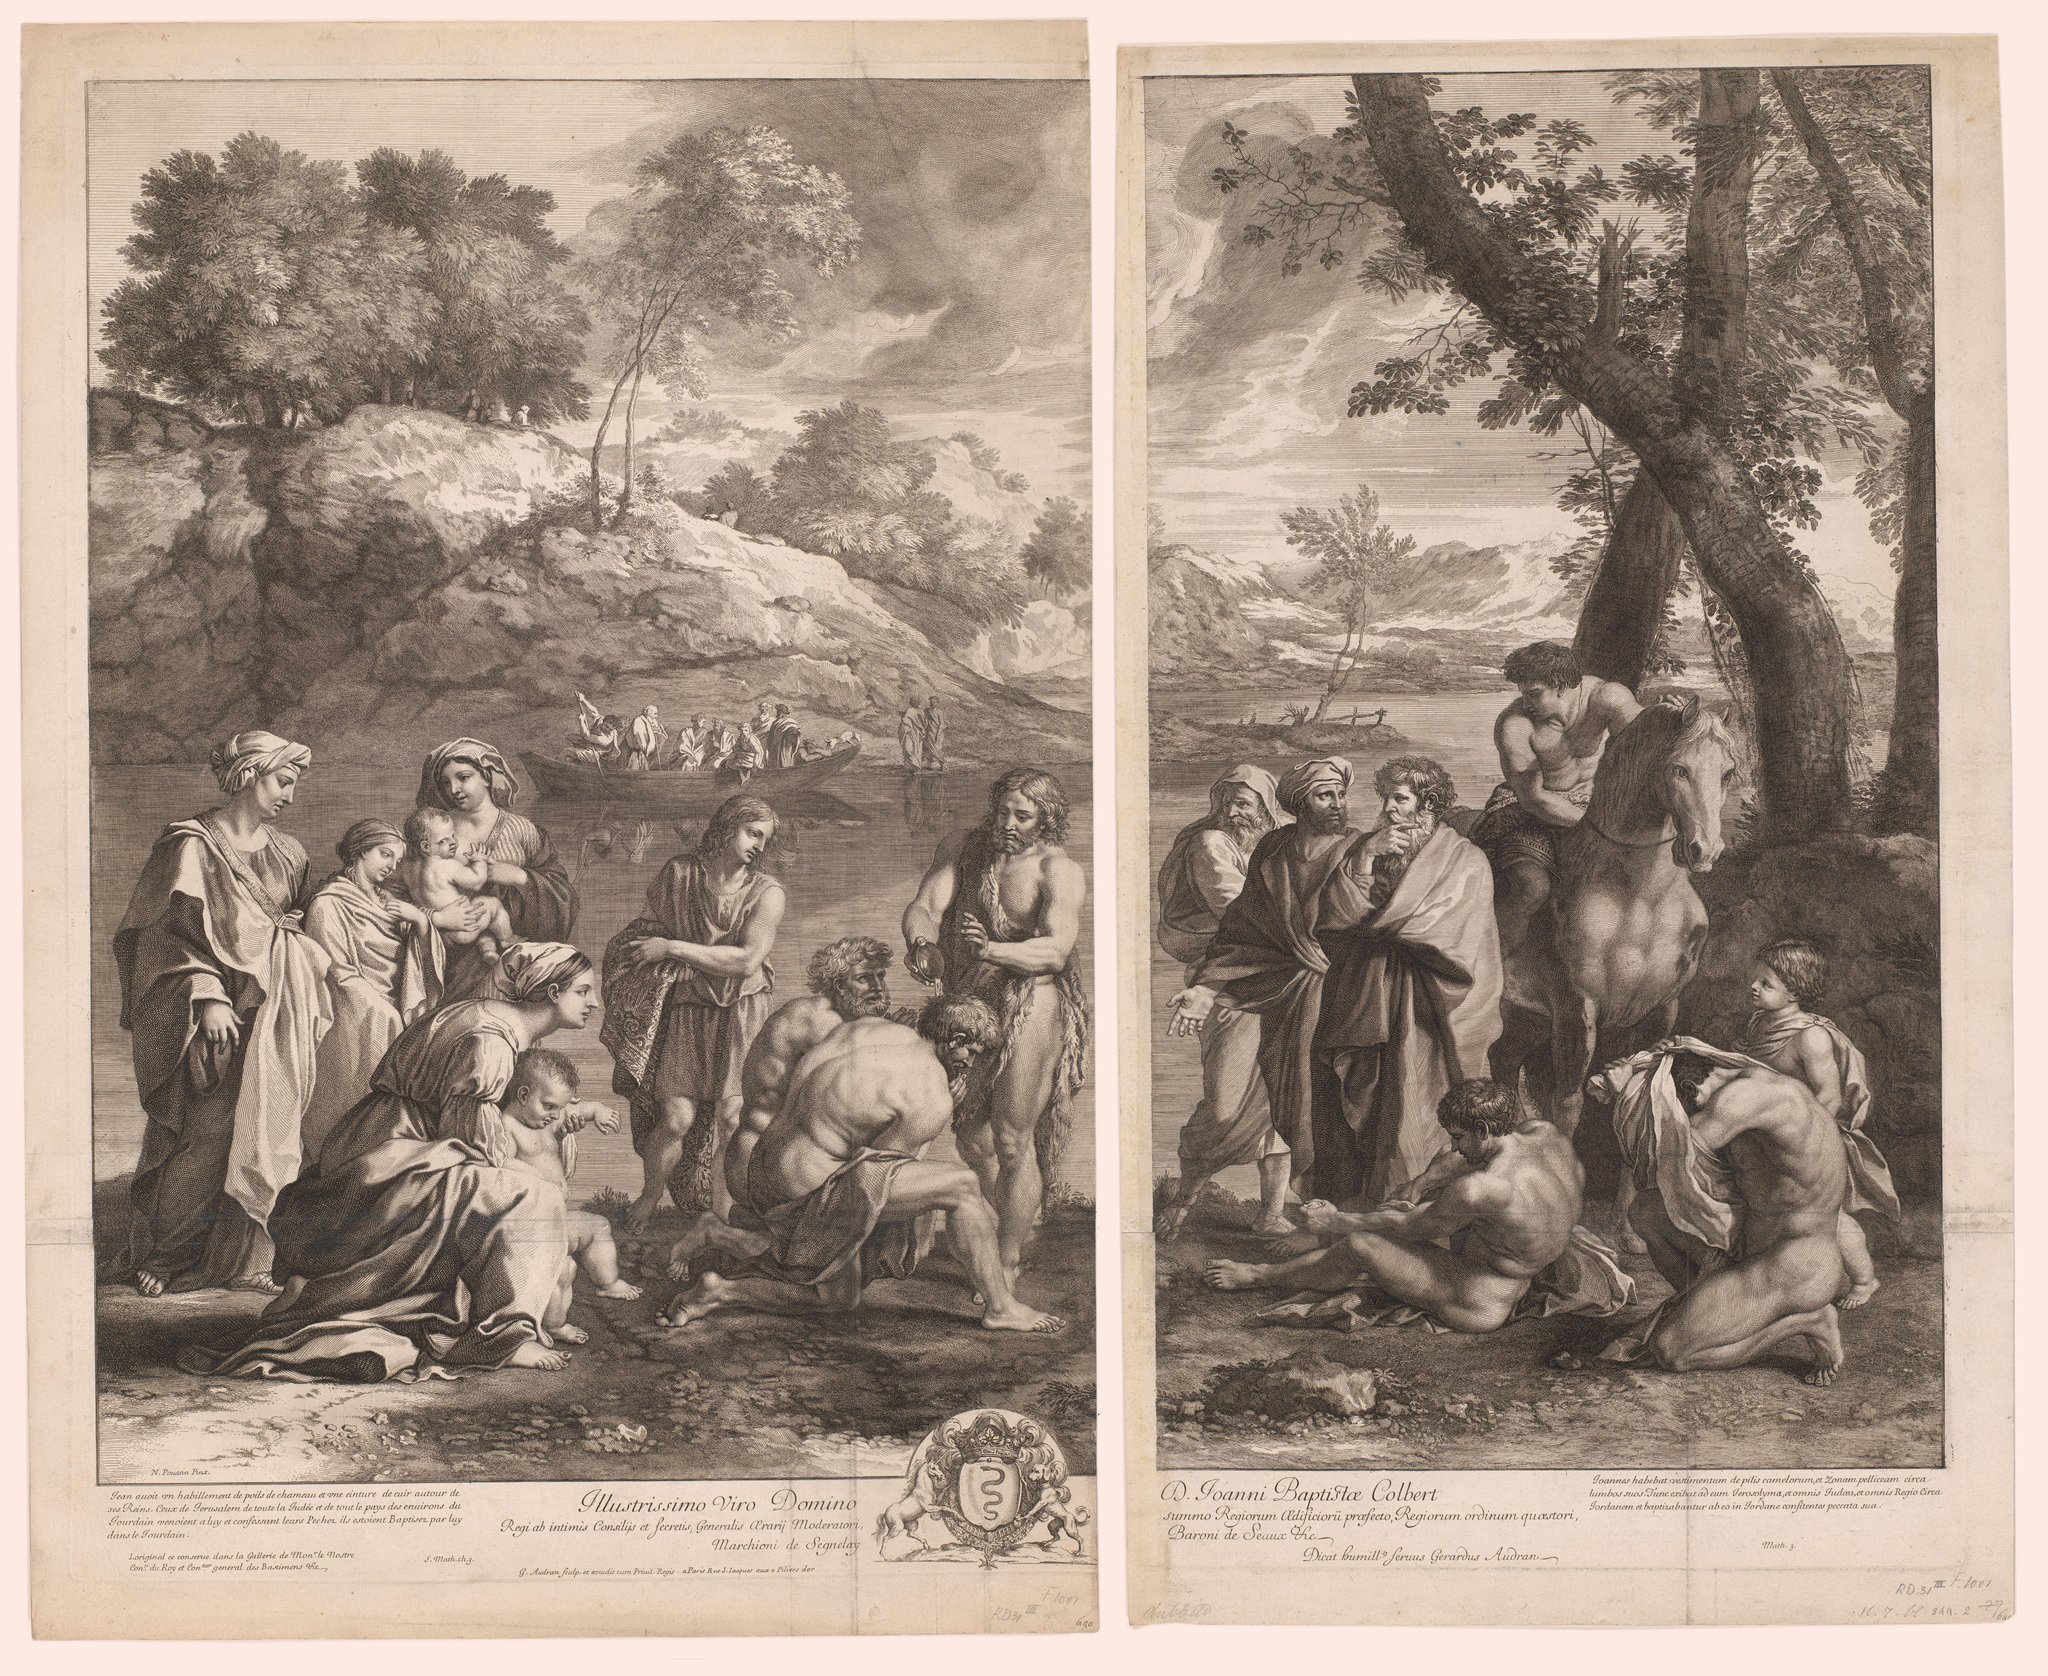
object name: print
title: Johannes doopt de Farizeeërs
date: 1677-1683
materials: paper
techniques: engraving, etching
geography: paris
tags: series of scenes from the life of john the baptist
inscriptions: collector's mark: Lugt 2228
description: Dit object is omwille van een betere presentatie virtueel samengevoegd, maar bestaat fysiek uit losse onderdelen.